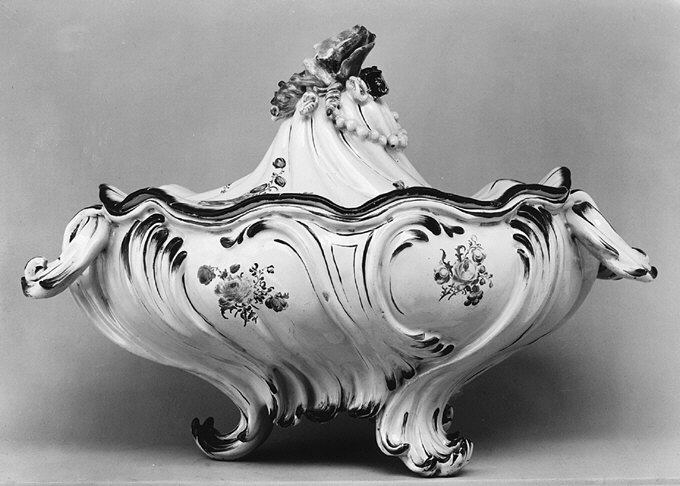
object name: tureen with cover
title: Tureen with cover (part of a set)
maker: pierre chapelle ii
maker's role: draftsman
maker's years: 1684-1760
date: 1760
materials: faience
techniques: glazing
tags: flowers